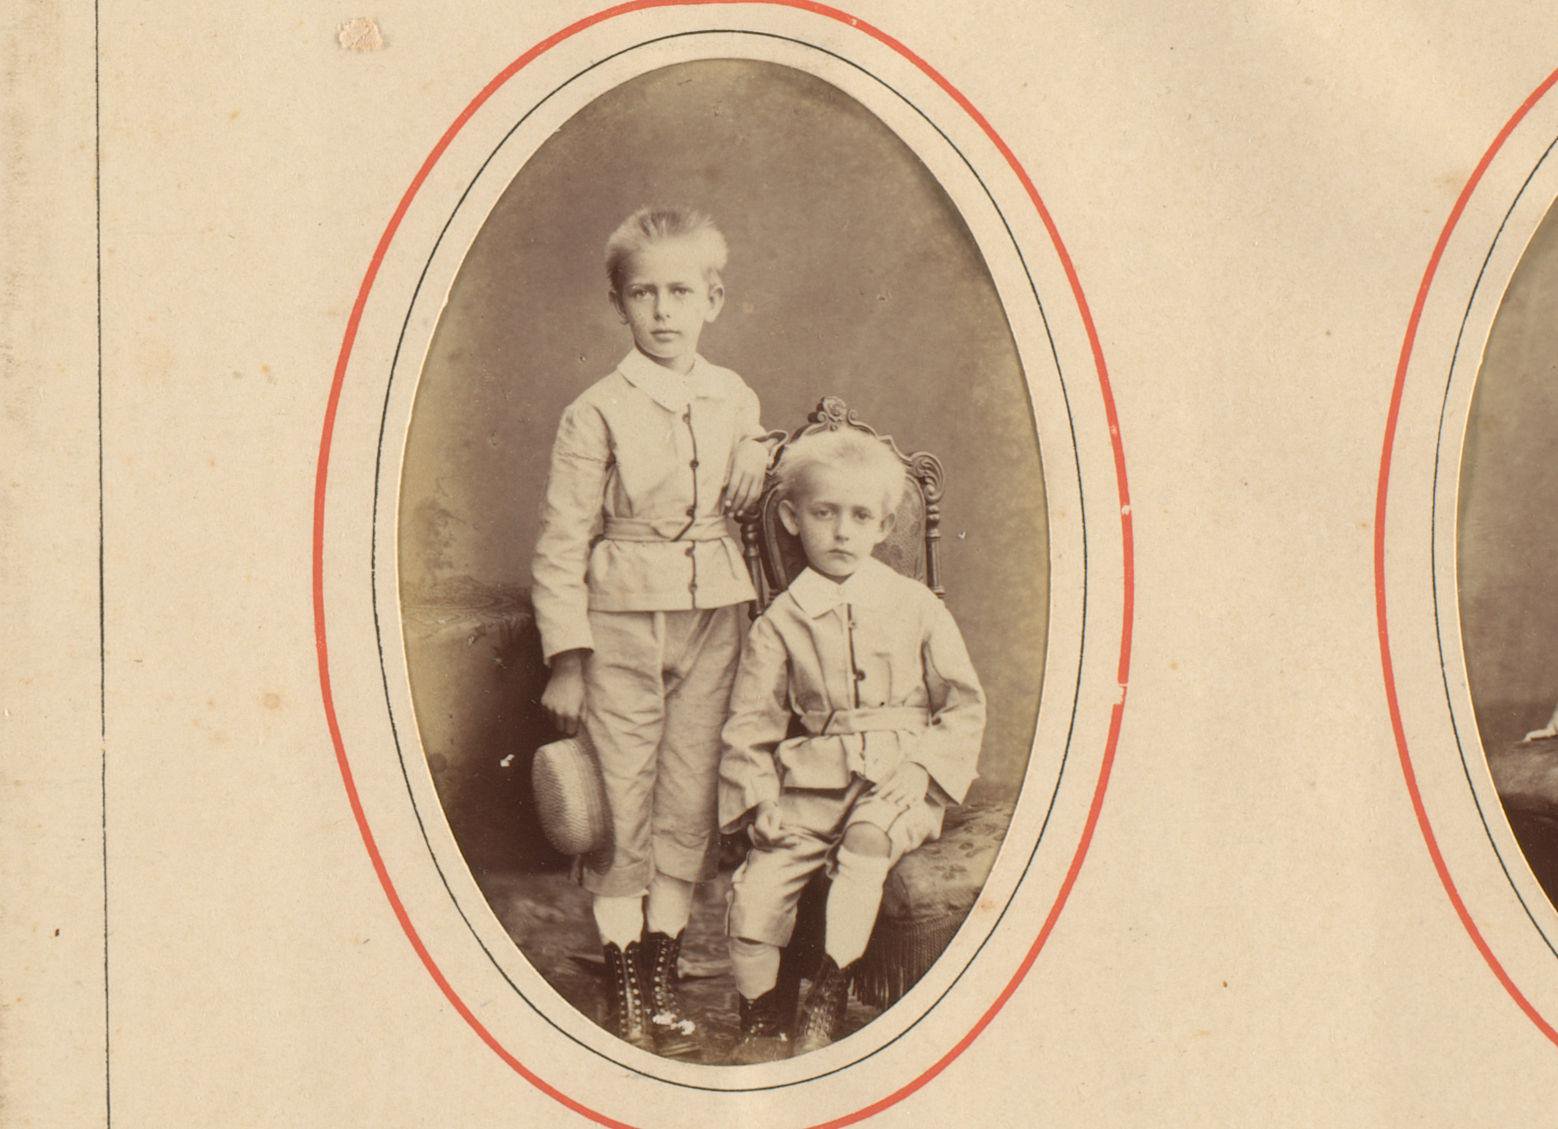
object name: album leaf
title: Portret van twee jongens, aangeduid als Herman en Anton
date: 1870-1890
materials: cardboard, paper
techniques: albumen print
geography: batavia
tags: anonymous historical persons portrayed in a double portrait